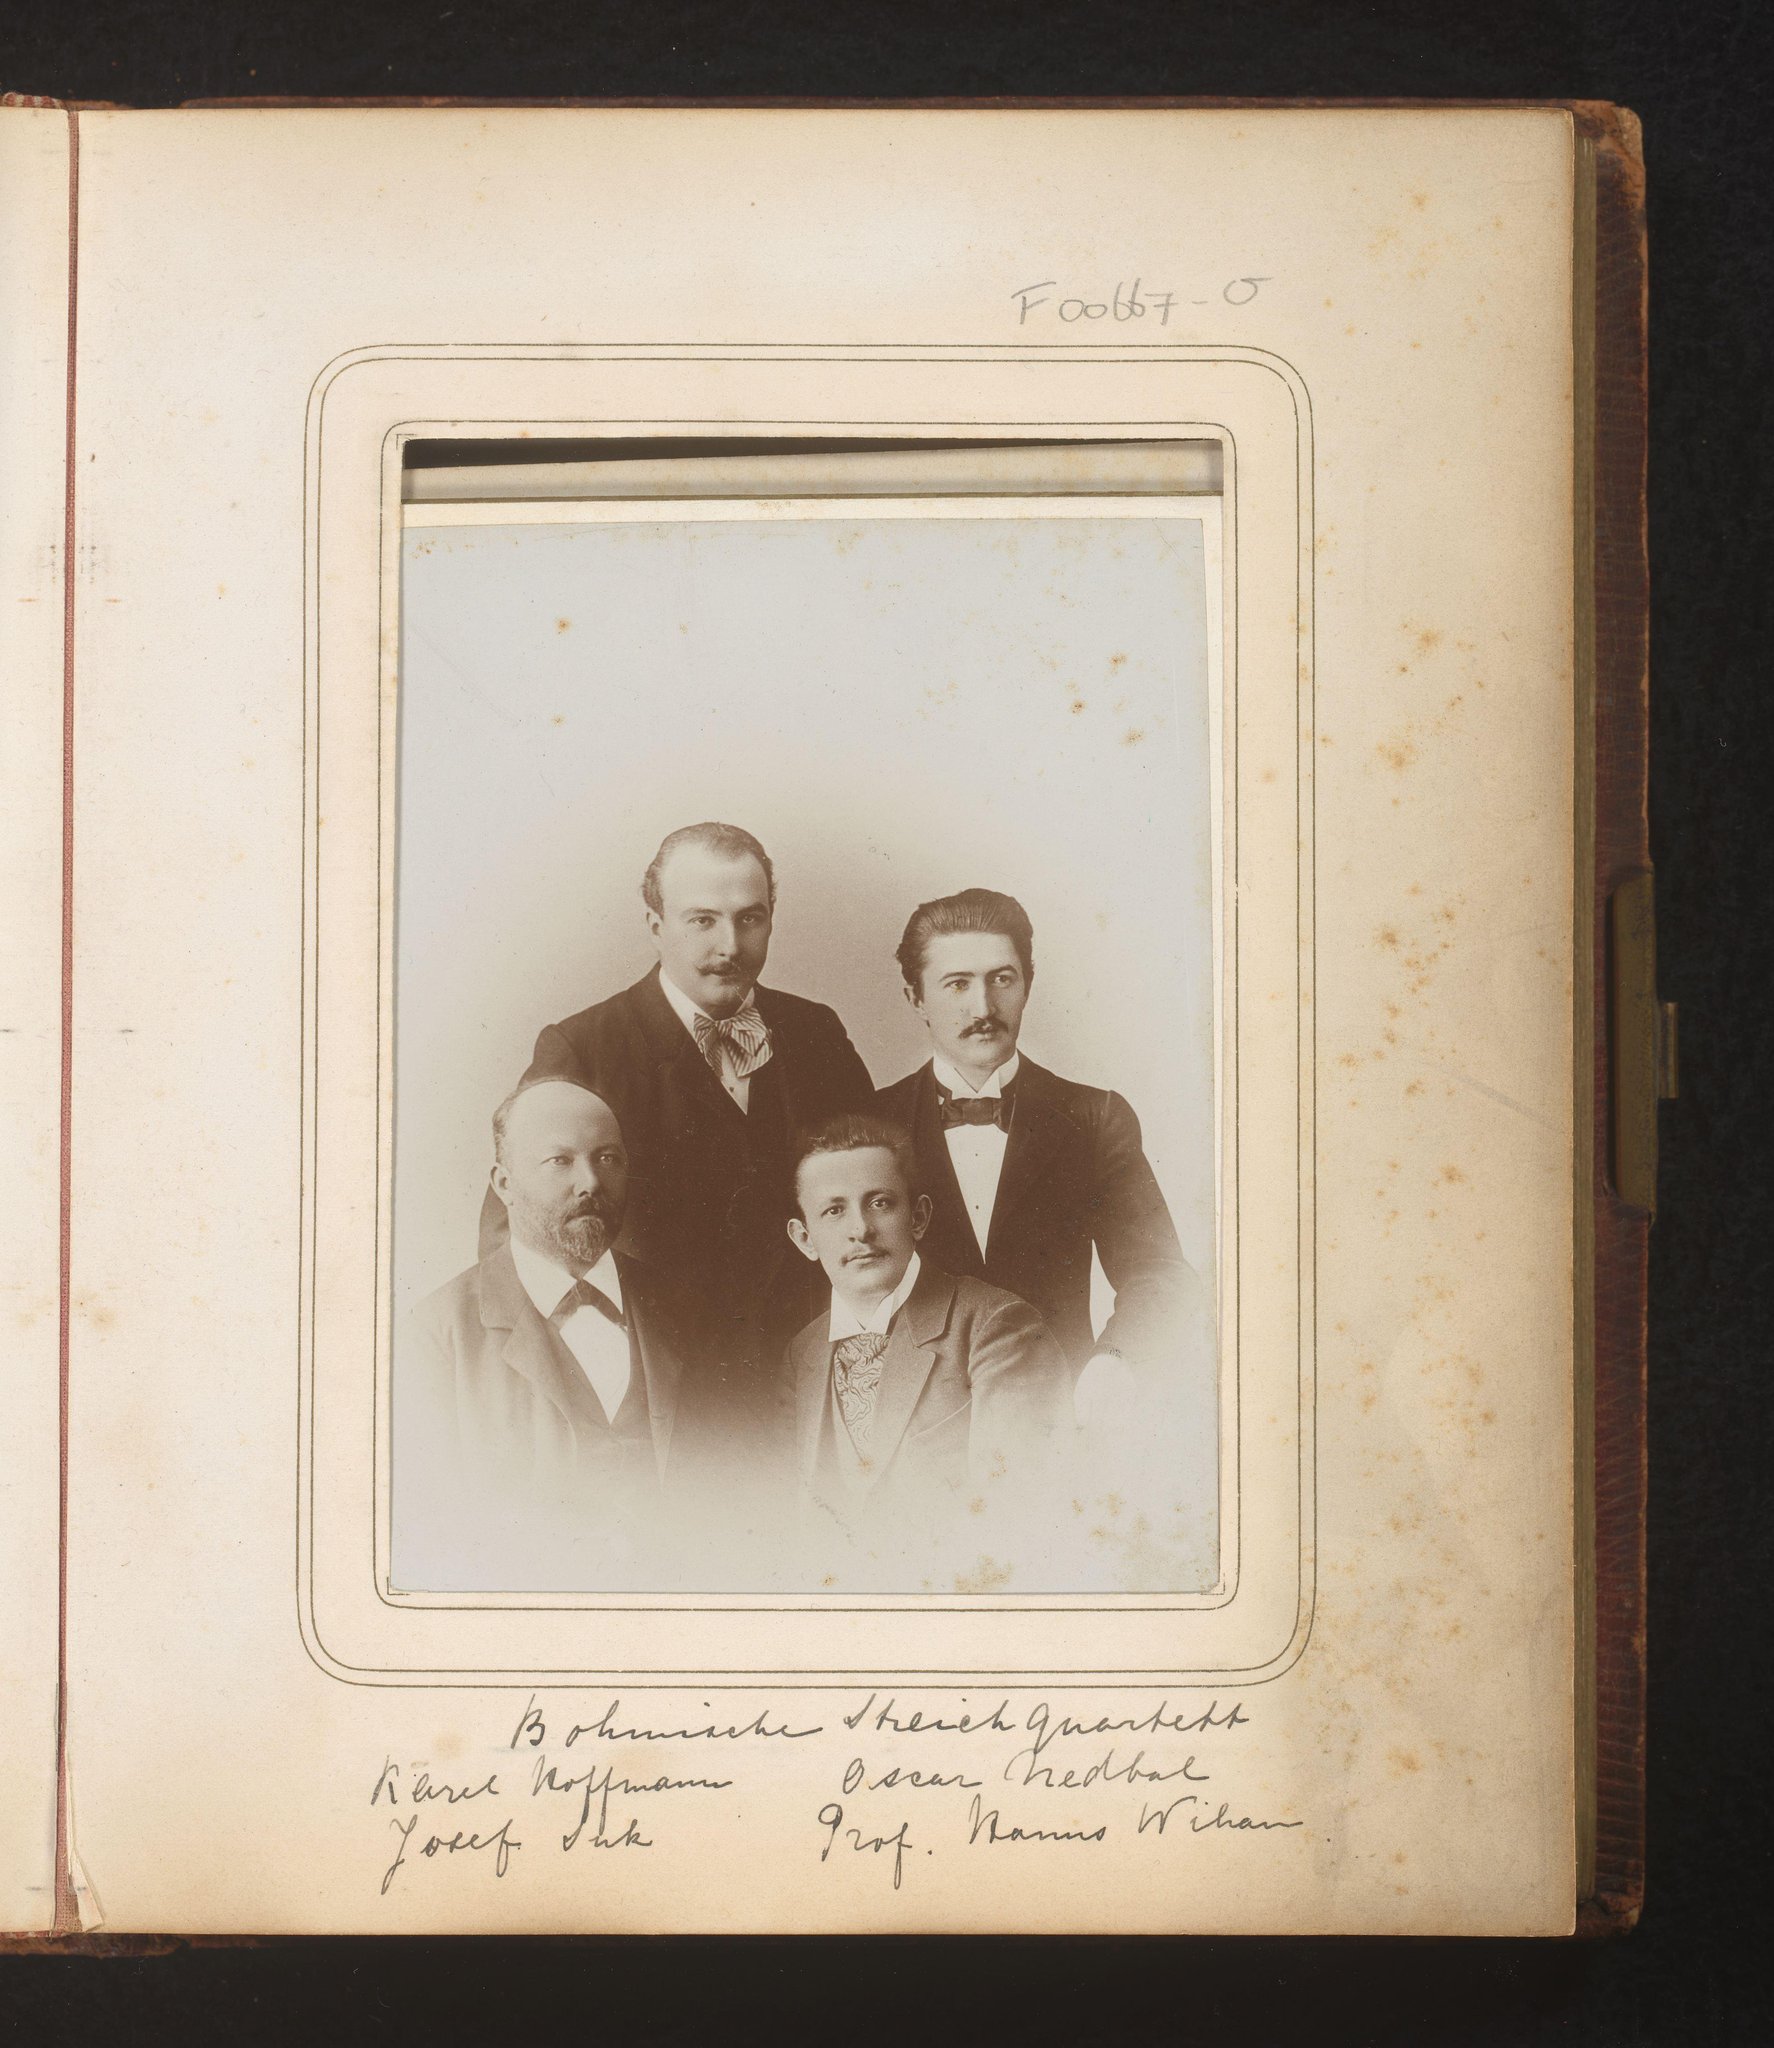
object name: cabinet photograph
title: Groepsportret van het Bohmische Streichquartett, bestaande uit Karel Hoffmann, Oscar Nedbal, Jozef Suk en Hanuš Wihan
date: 1880-1910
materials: cardboard, photographic support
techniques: collodion silver print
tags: prague, musician, small group of musicians, chamber orchestra, jazz band, historical persons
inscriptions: annotation: ‘Bohmische Streichquartett/ (...)’